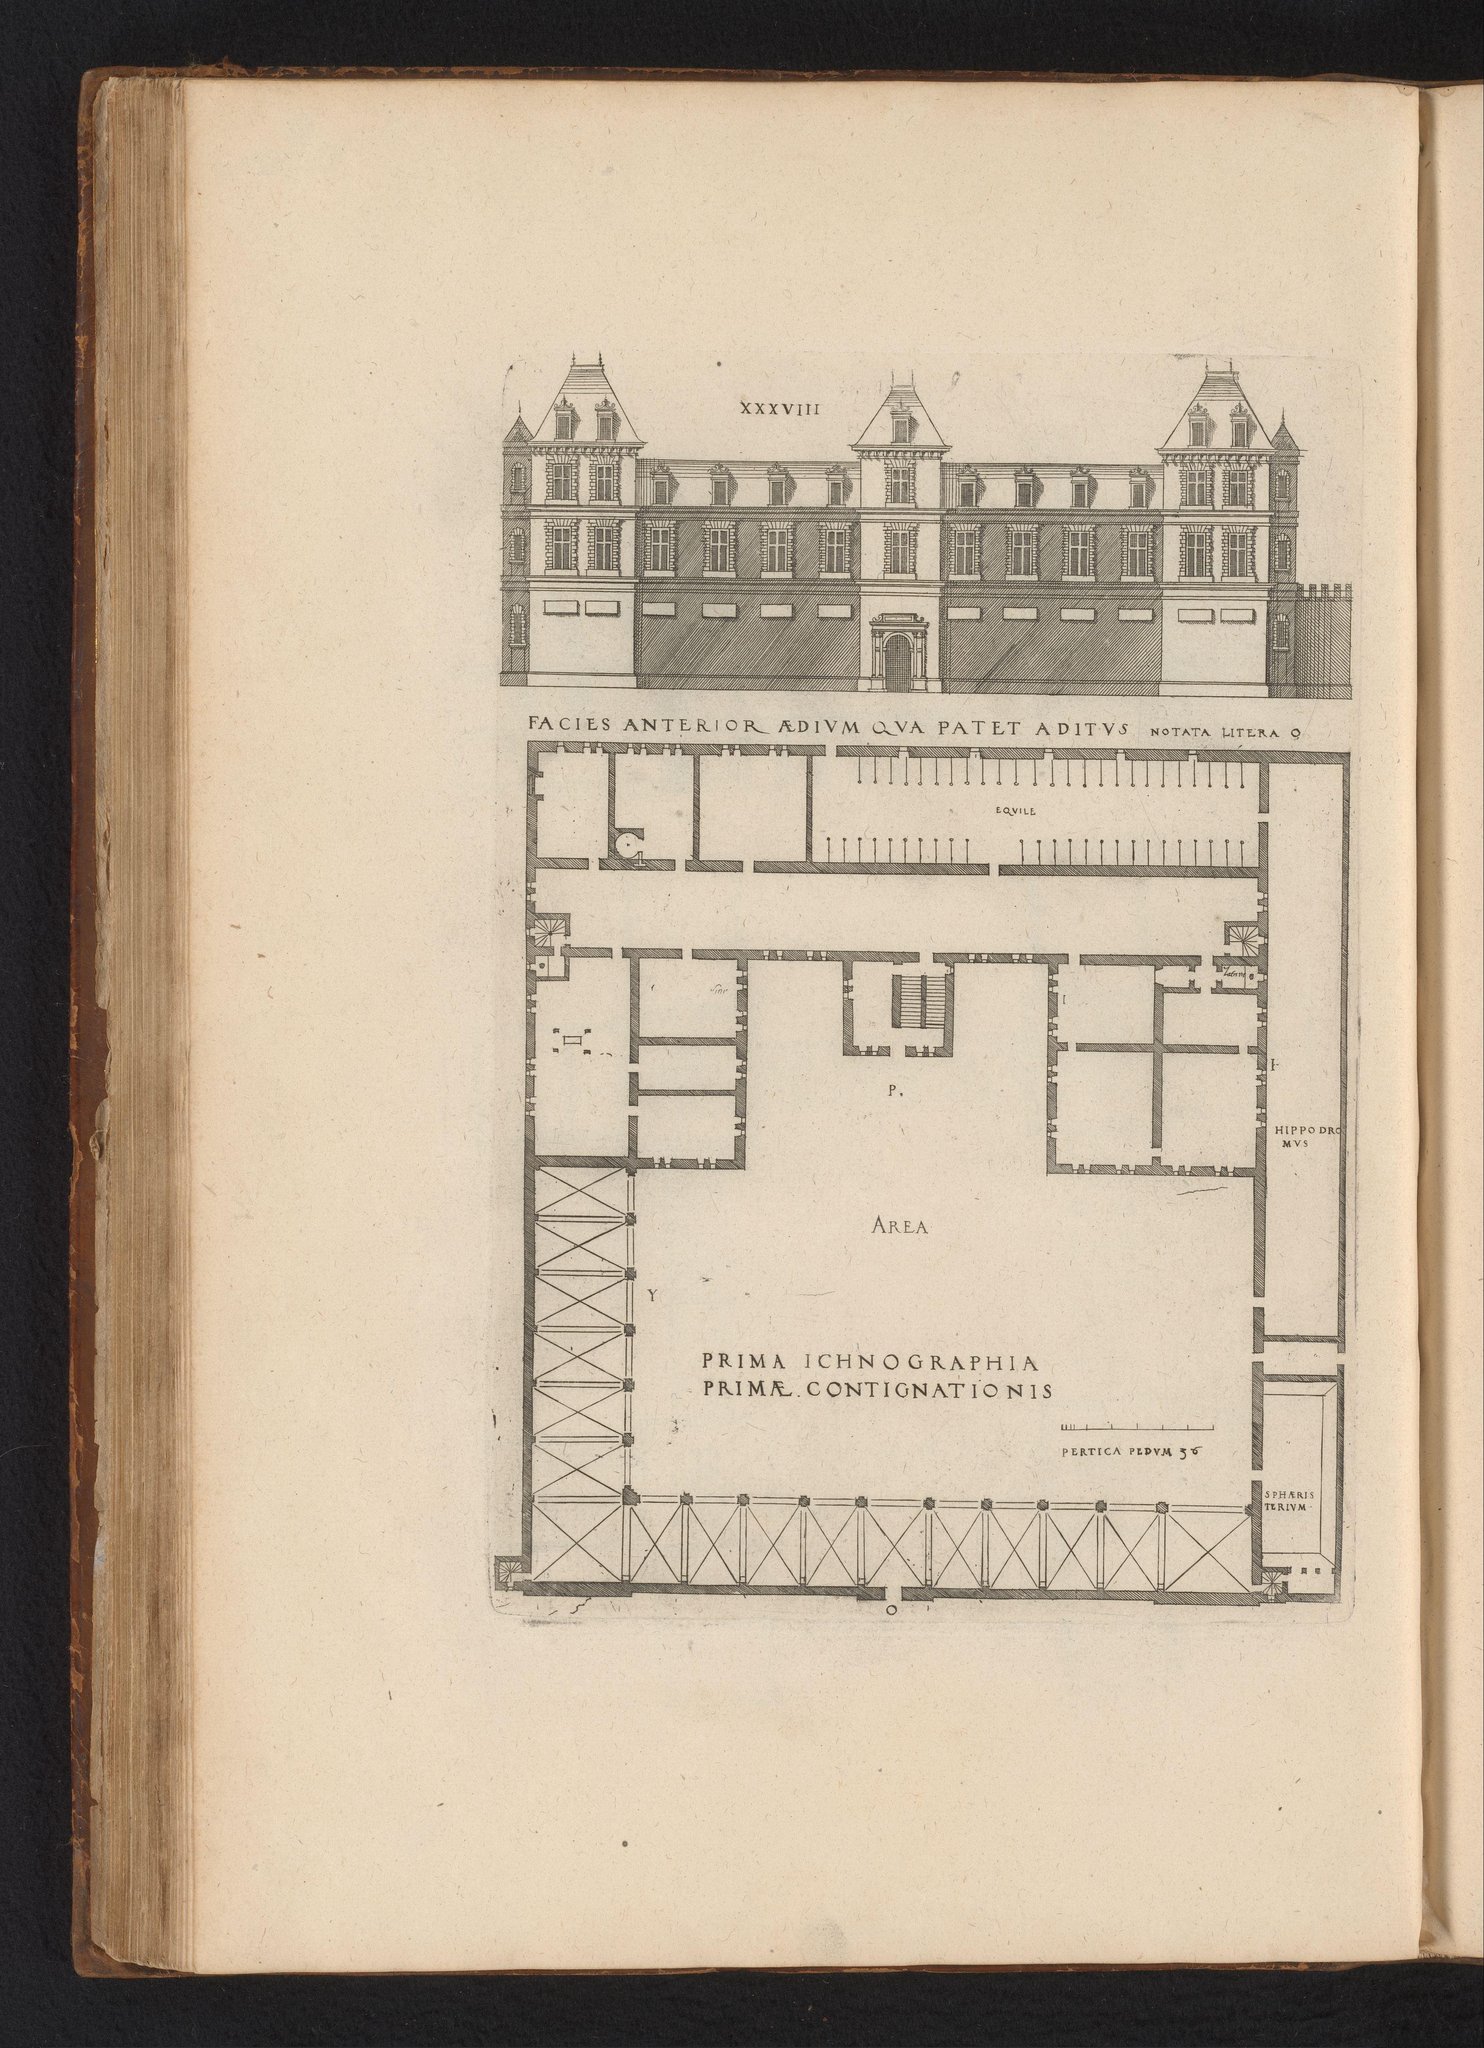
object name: ornament print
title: Voorgevel en plattegrond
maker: jacques androuet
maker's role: draughtsman, print maker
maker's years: 1515-1584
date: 1559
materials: paper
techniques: etching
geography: paris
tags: architectural design or model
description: Voorgevel en plattegrond. Aanzicht en plattegrond van architectuur. Genummerd: XXXVIII. Onderdeel van 'De architectura Iacobi Androuetii du Cerceau' (1559): 69 etsen met 171 voorstellingen van architectuur en ornamentiek.